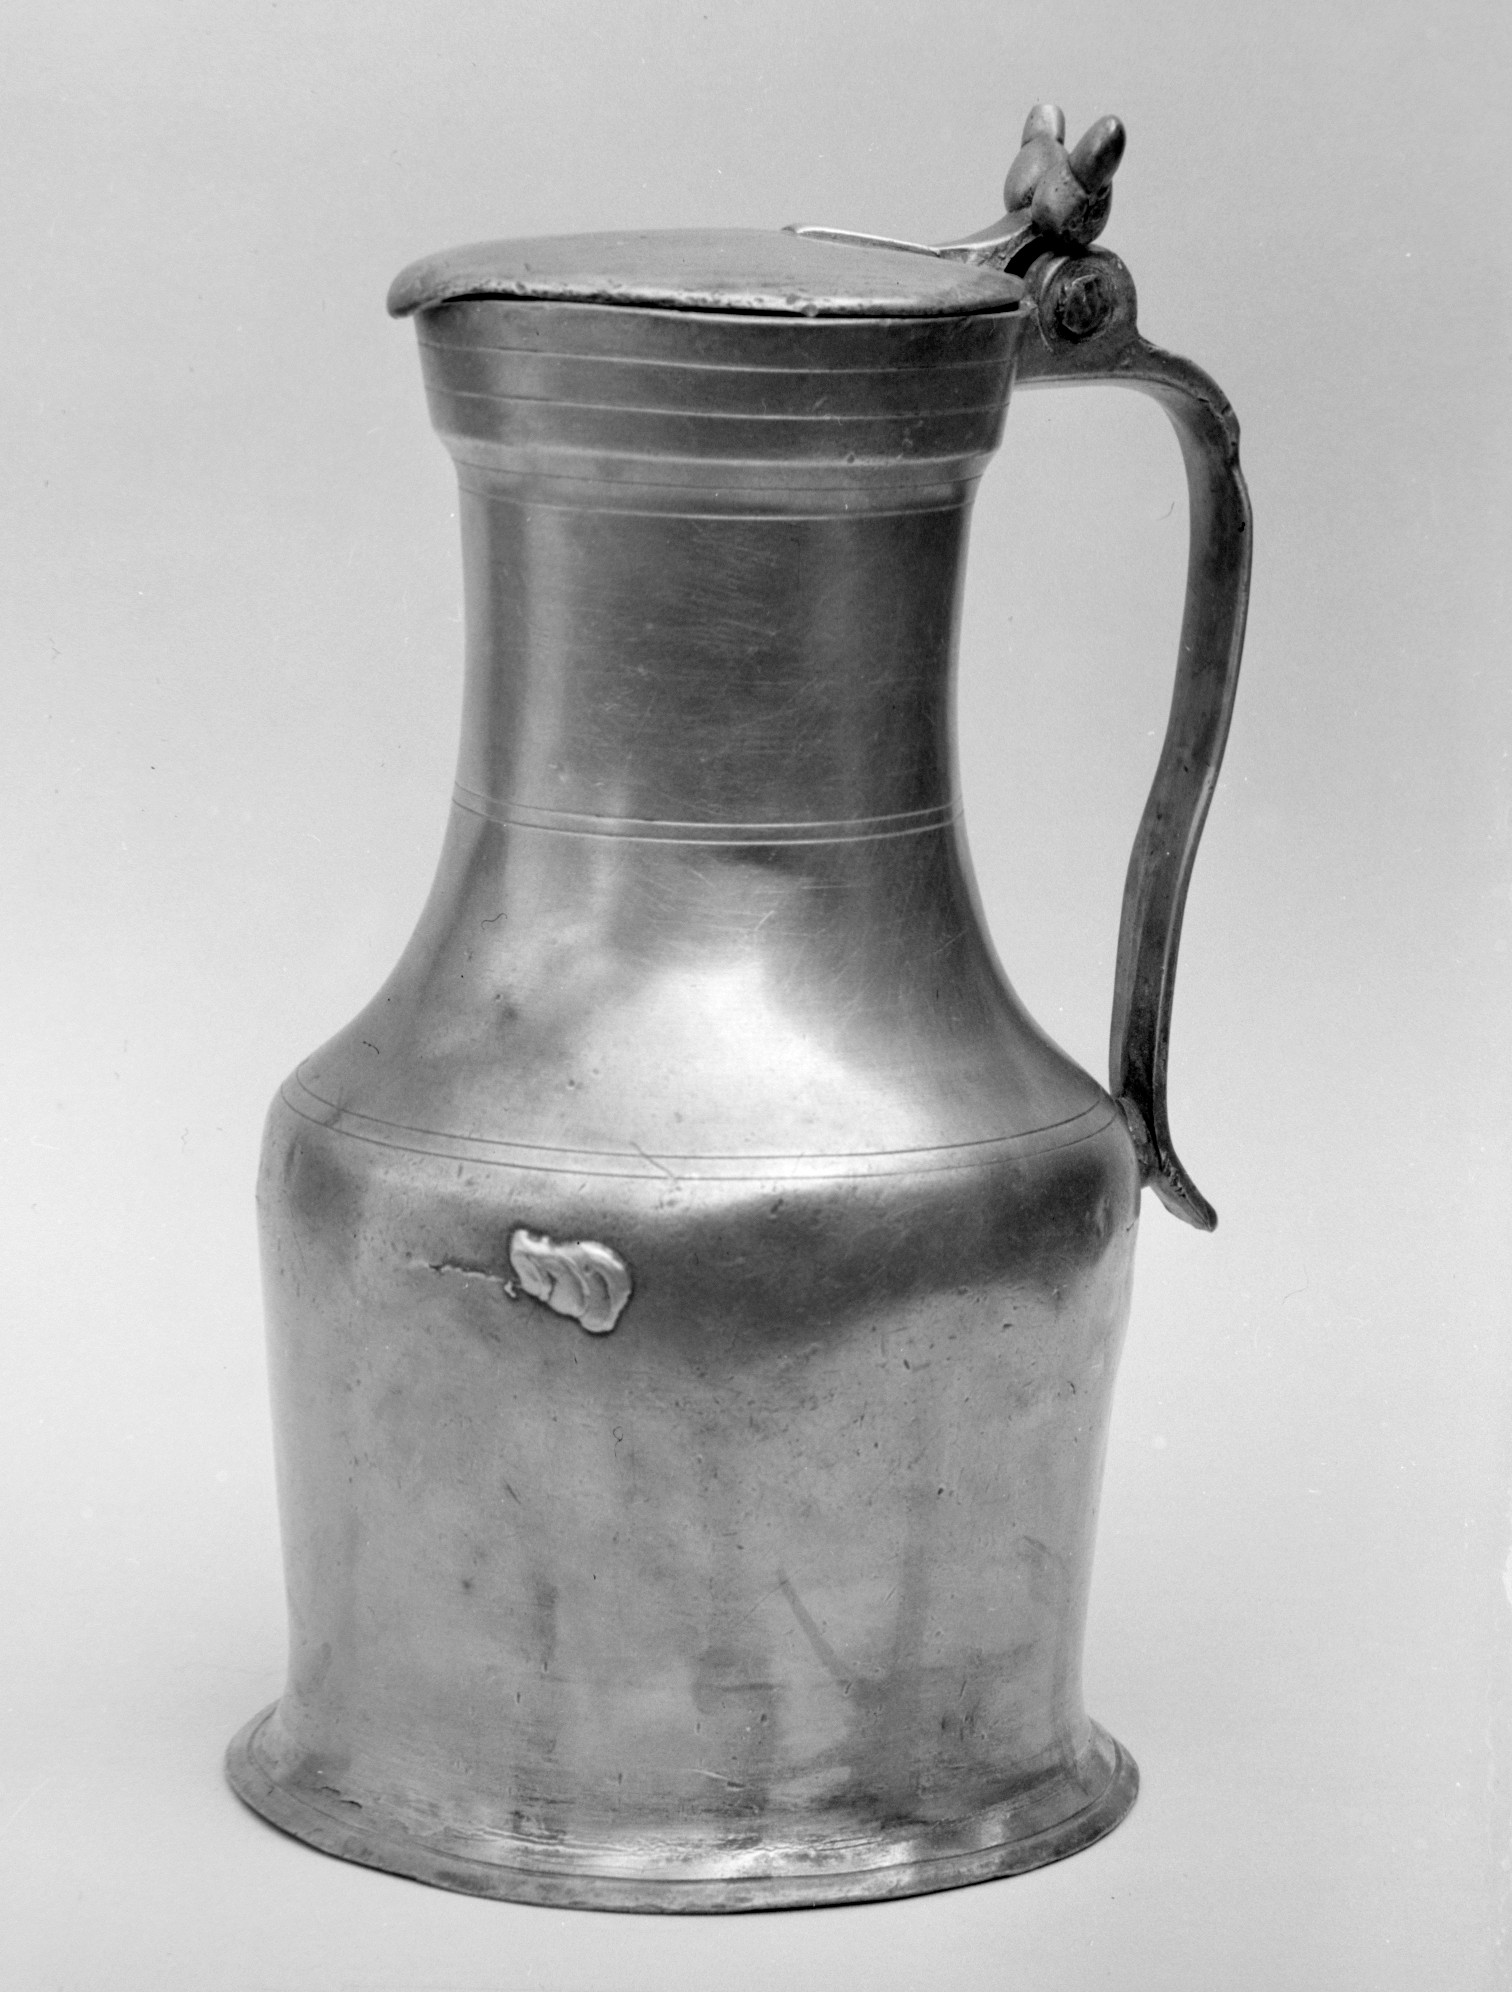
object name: pitcher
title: Pair of pitchers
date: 1701-1800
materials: pewter